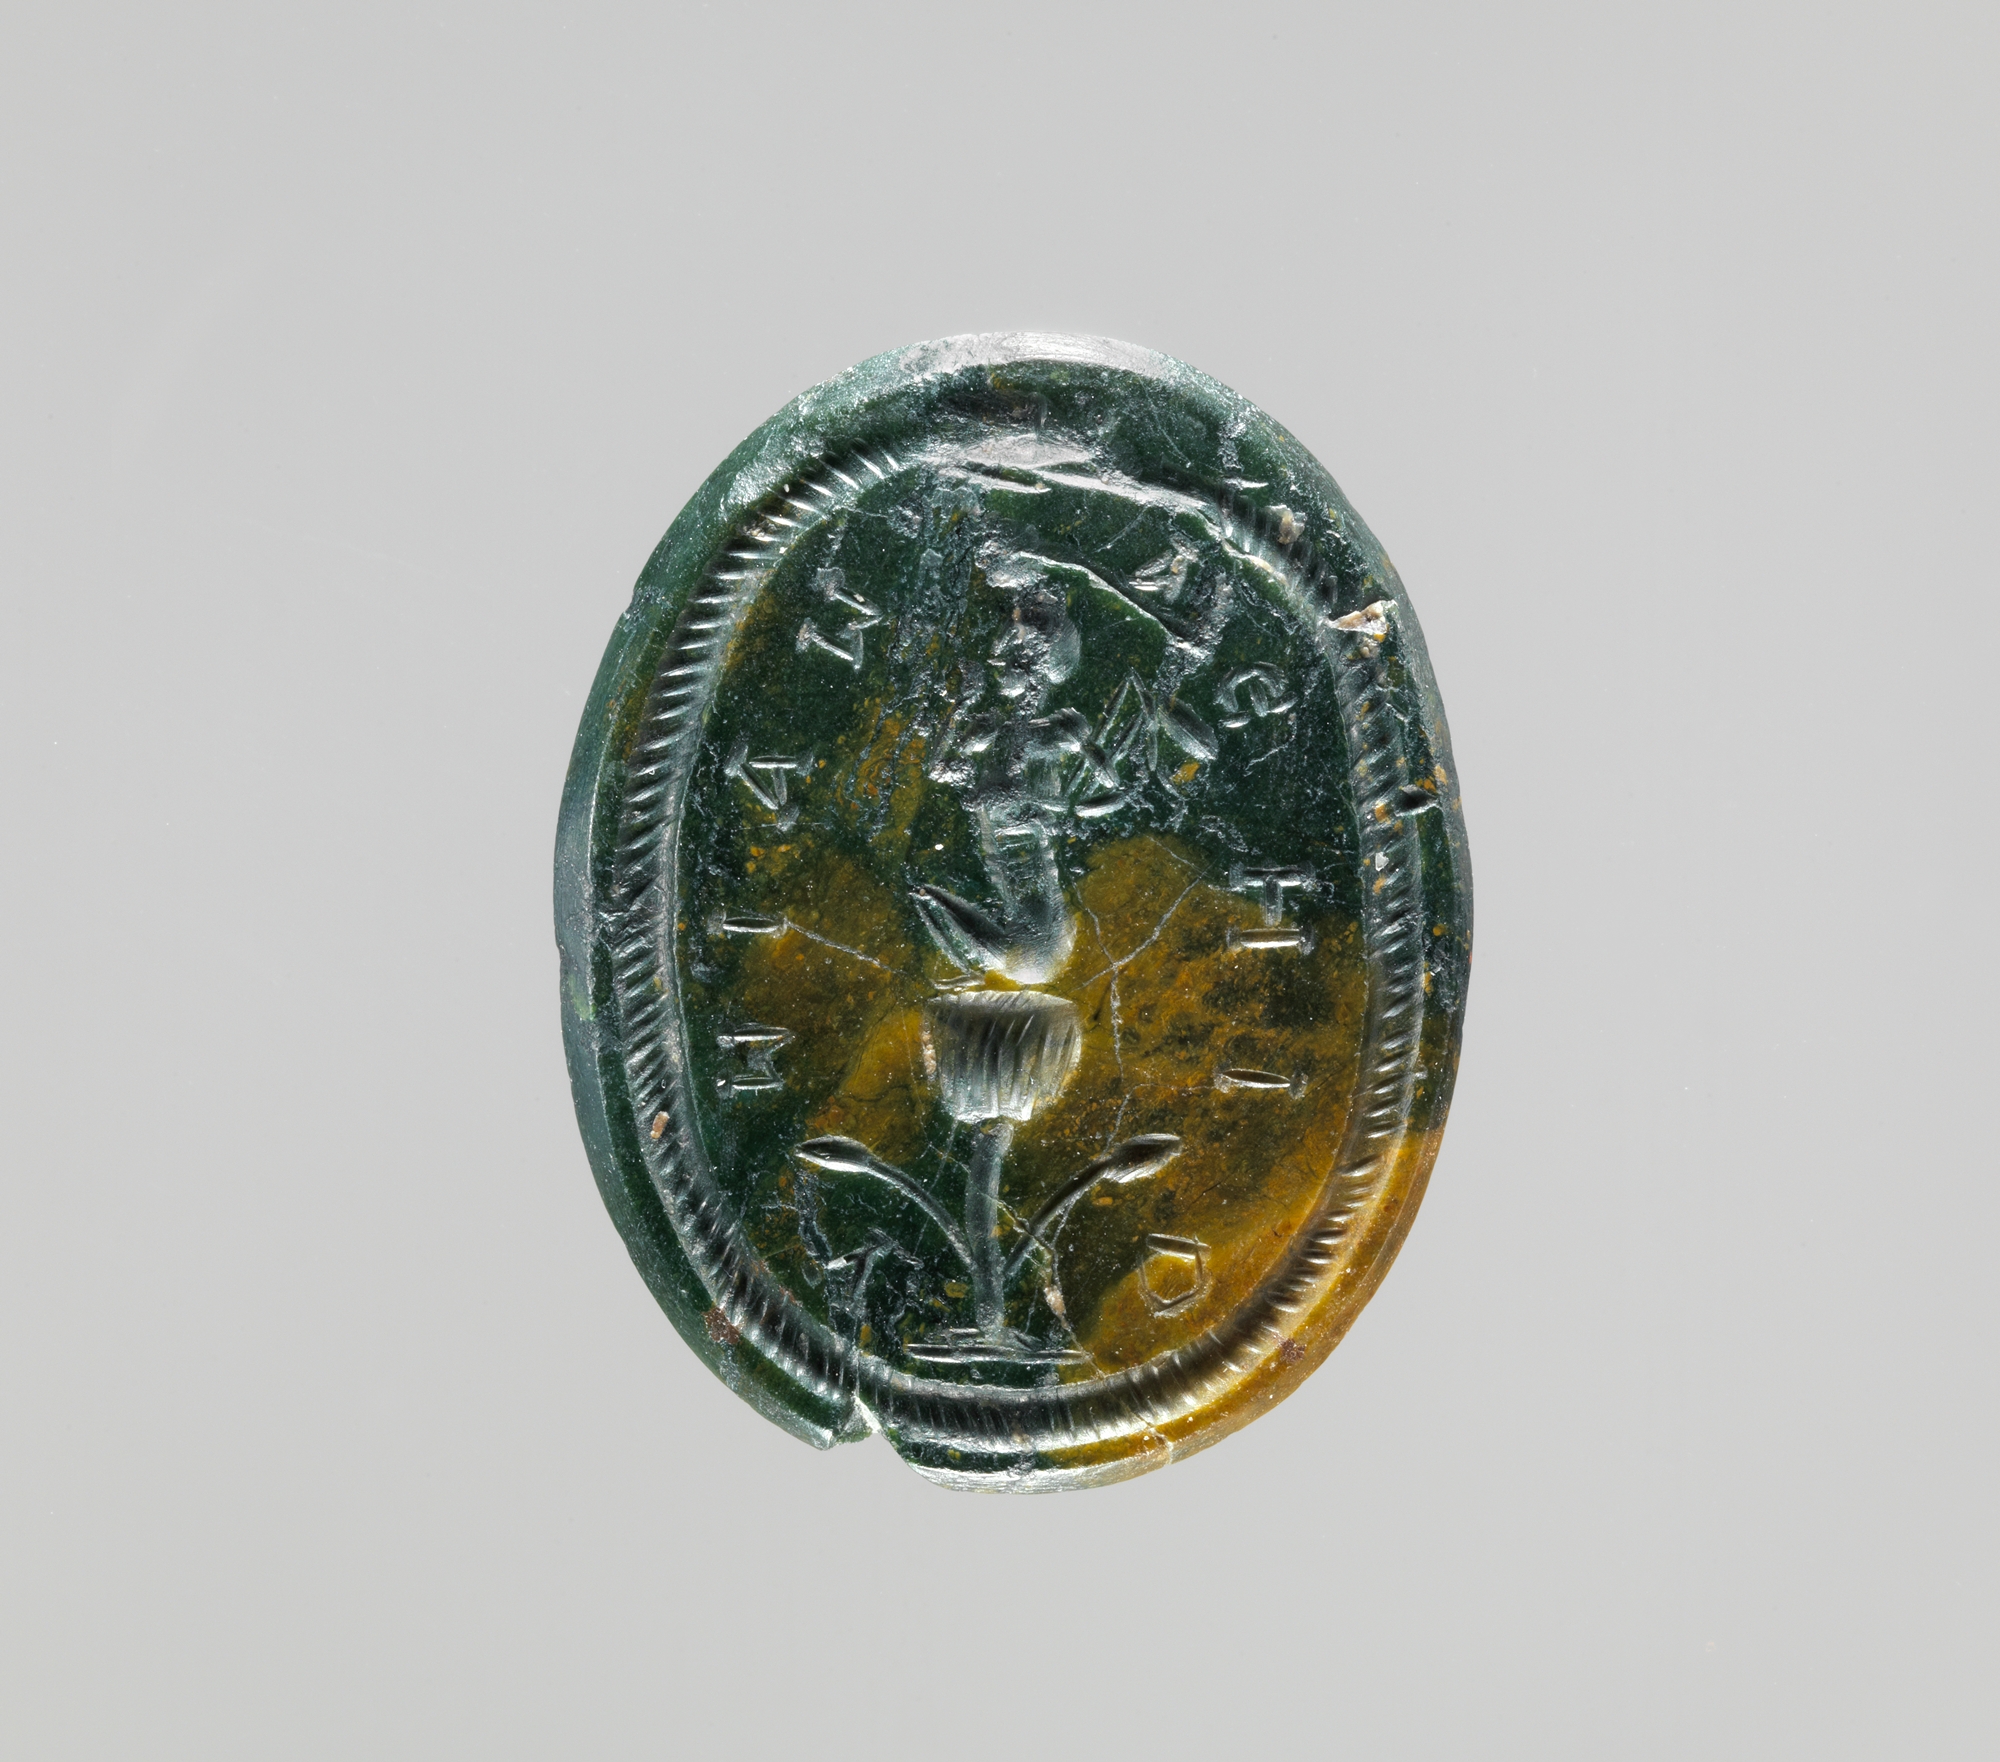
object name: intaglio, magical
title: Jasper intaglio: Harpocrates seated on a lotus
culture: roman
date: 101-300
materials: jasper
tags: lotuses,harpokrates